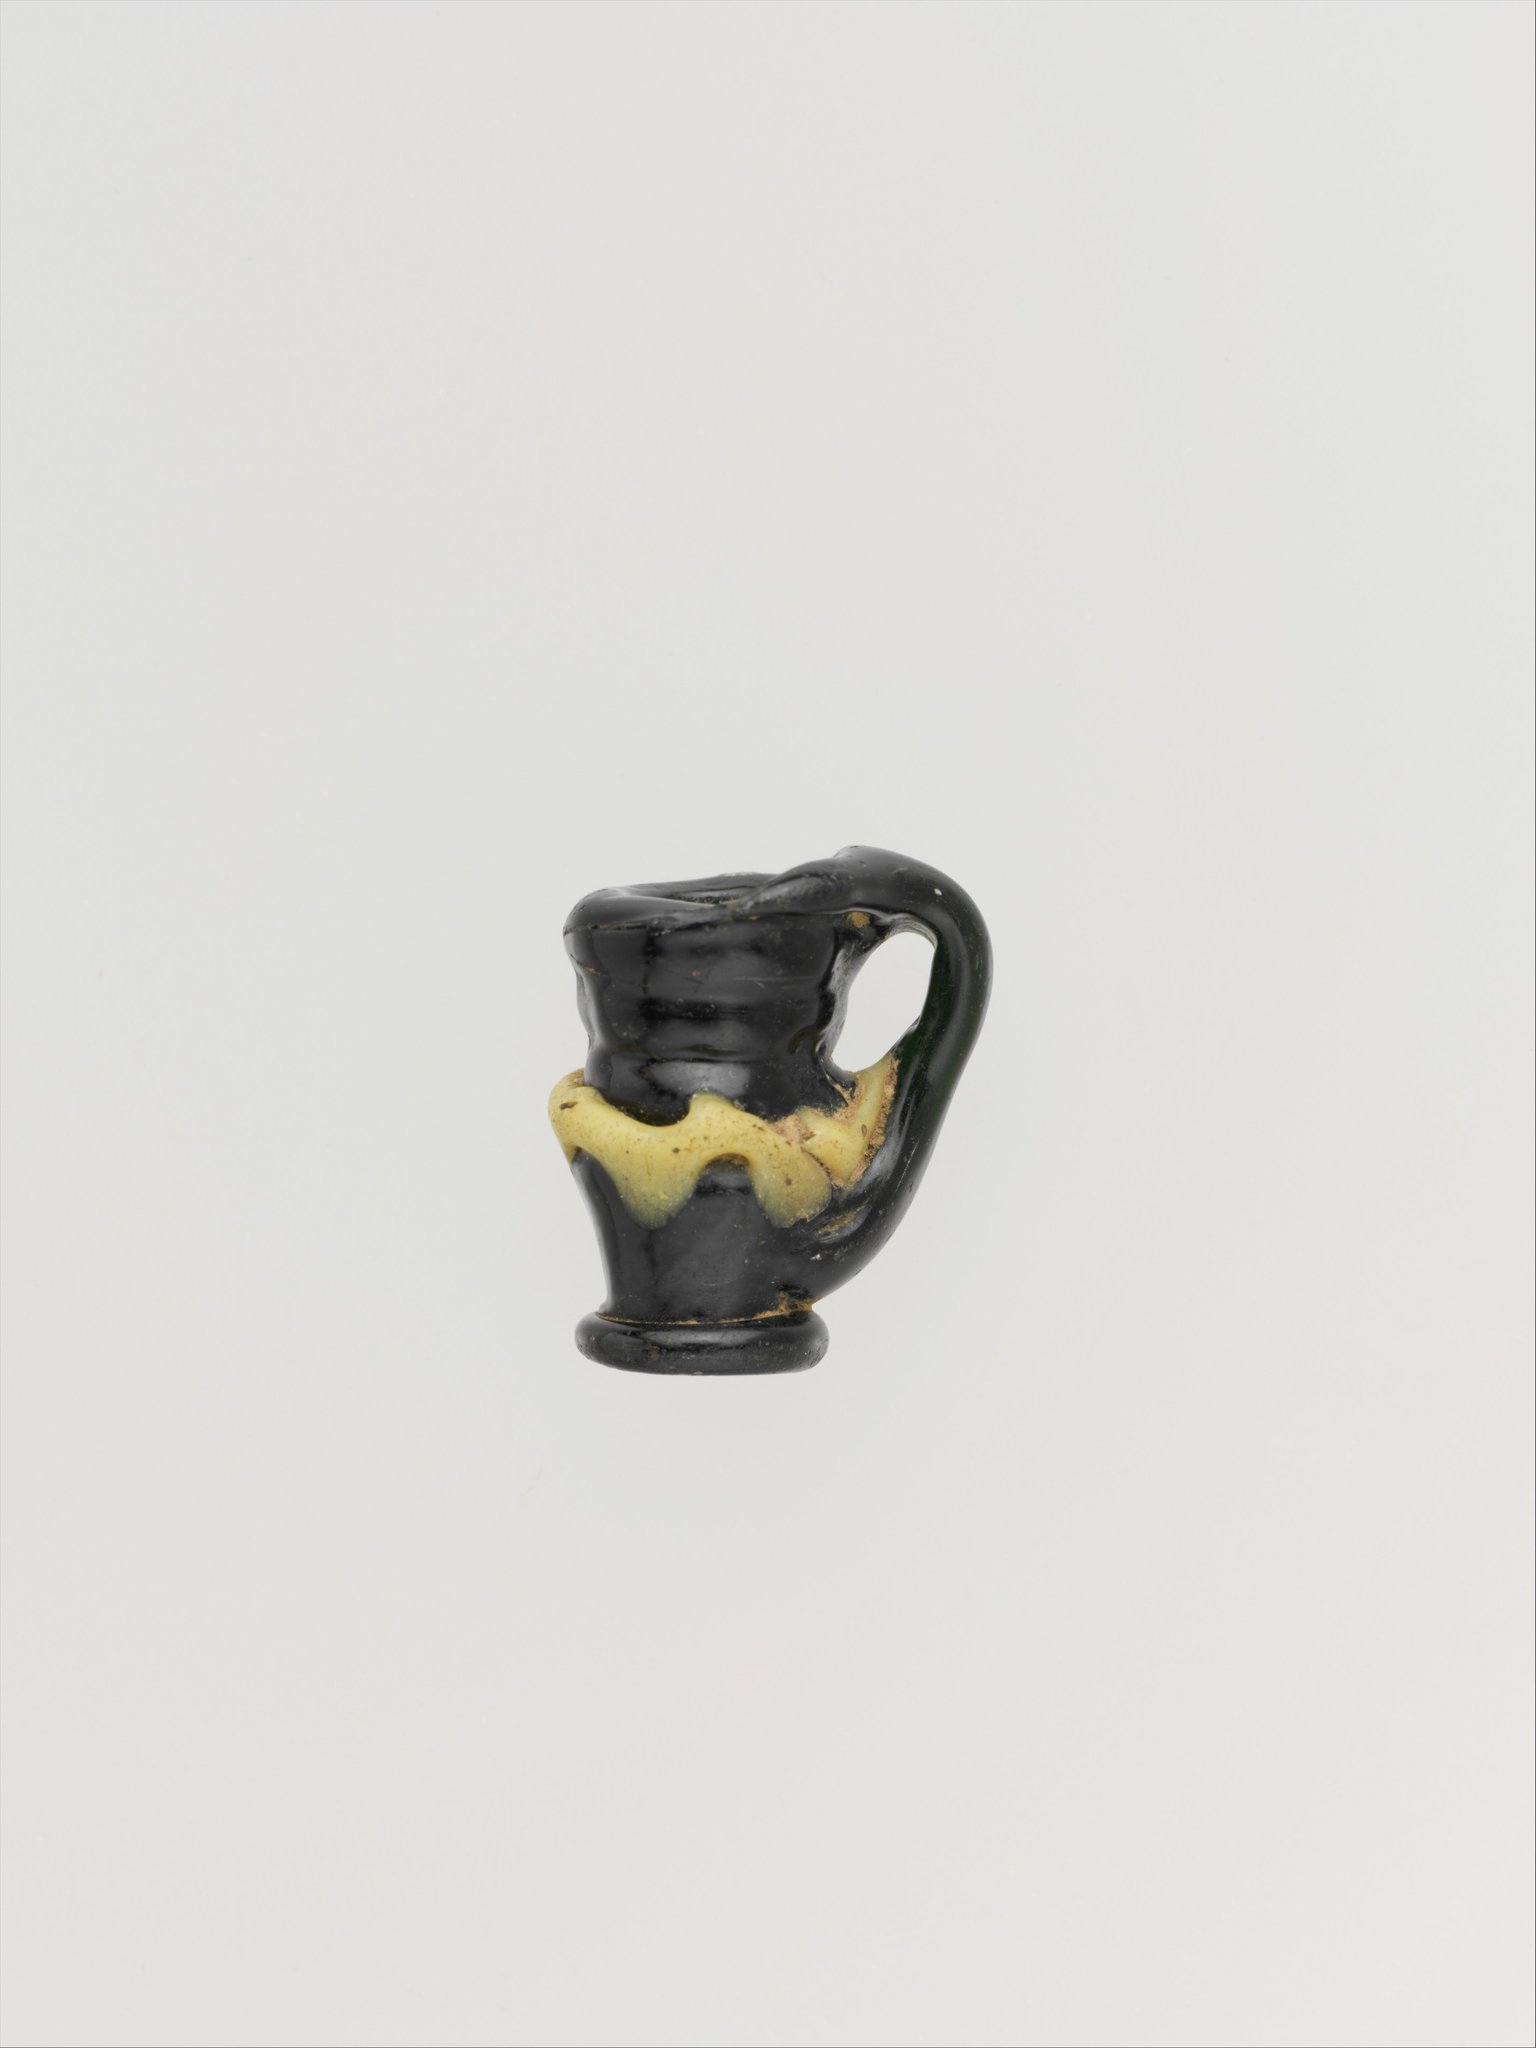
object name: pendant in the form of a vase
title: Glass pendant shaped like a jug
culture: roman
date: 301-400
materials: glass